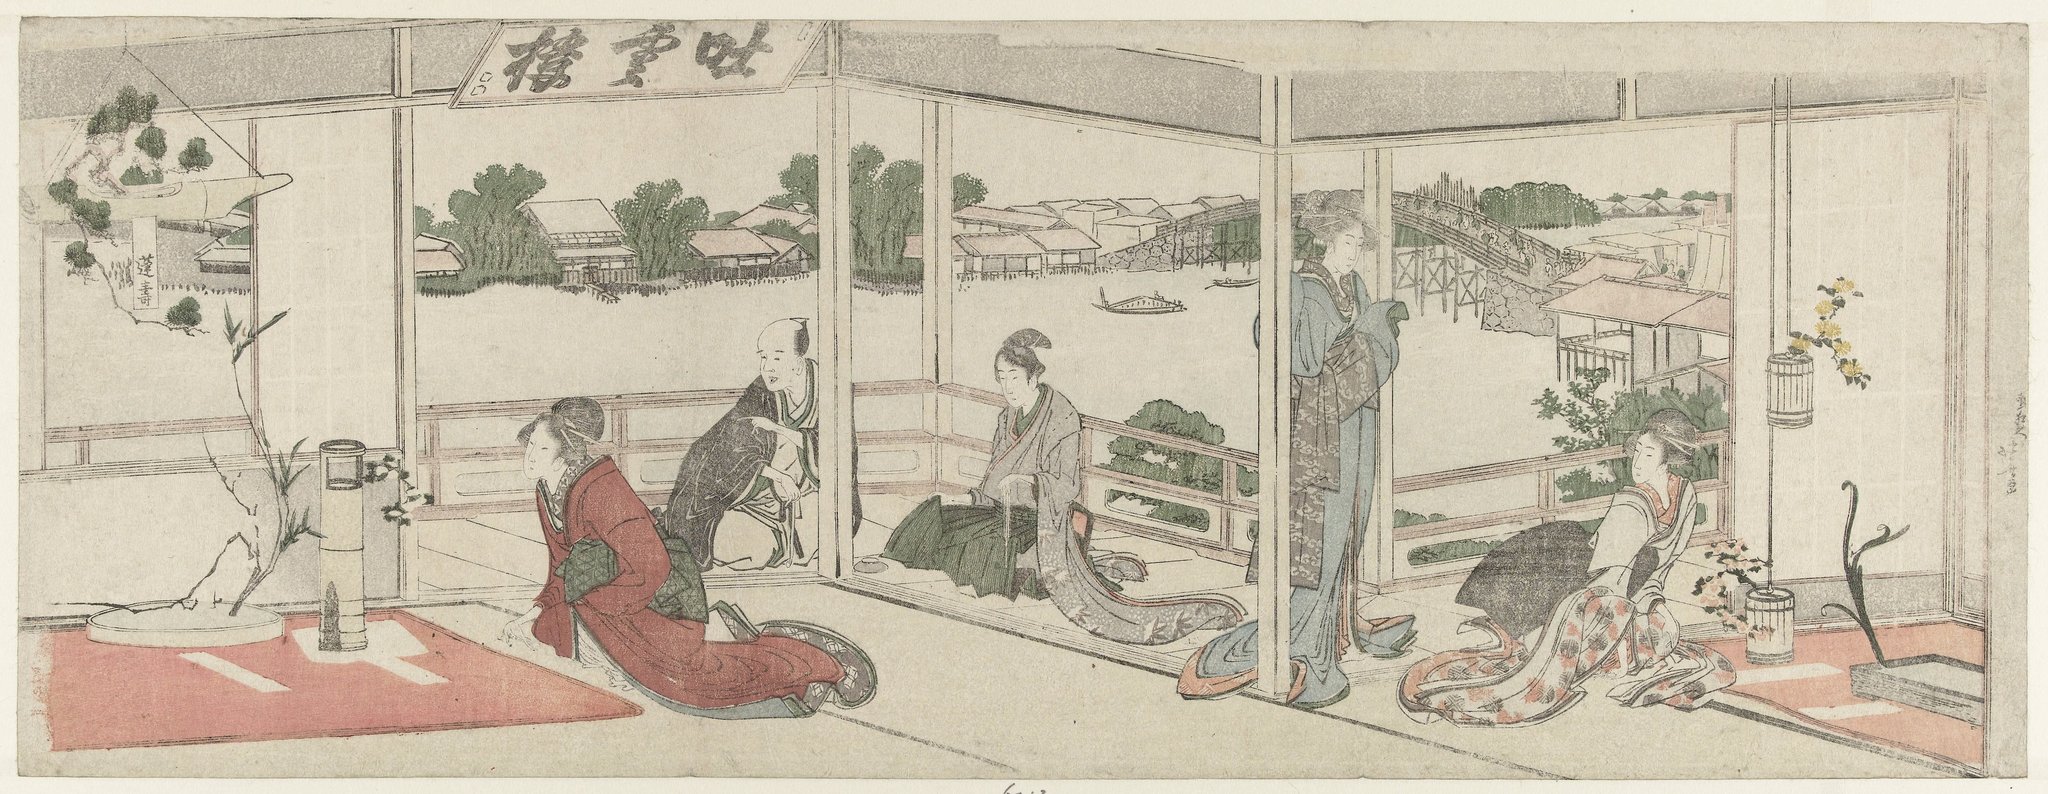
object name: print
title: Viewing Flower Arrangements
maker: katsushika hokusai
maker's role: draughtsman, print maker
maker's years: 1760-1849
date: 1800-1810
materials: paper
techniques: blind stamped, woodcut, nishiki e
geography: japan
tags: river, plants; vegetation (+ flowers, blossom, blossoming), loggia, verandah, porch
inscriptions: collector's mark, recto, stamped: Lugt 2228, collector's mark, recto, stamped: Lugt 2760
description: Een surimono is een luxe uitgevoerde prent waarop beeld met één of meerdere gedichten gecombineerd is. Bij het drukken van een surimono werd vaak gebruik gemaakt van dikker papier, blinddruk en metaal pigmenten, zoals koper- en zilverpoeder. De prenten werden vaak in opdracht van dichters gemaakt en als exclusief geschenk aan vrienden en relaties gegeven. Van deze prent zijn minstens drie staten bekend. Op de eerste staat is de naam van elk bloemstuk op de witte strook ernaast gedrukt, énis de oude man op de veranda kaal. Op de tweede is de man nog steeds kaal en ontbreken de namen van de bloemstukken. In de derde (deze) staat ontbrekende de namen van de bloemstukken, en heeft de oudere man haar op zijn hoofd.